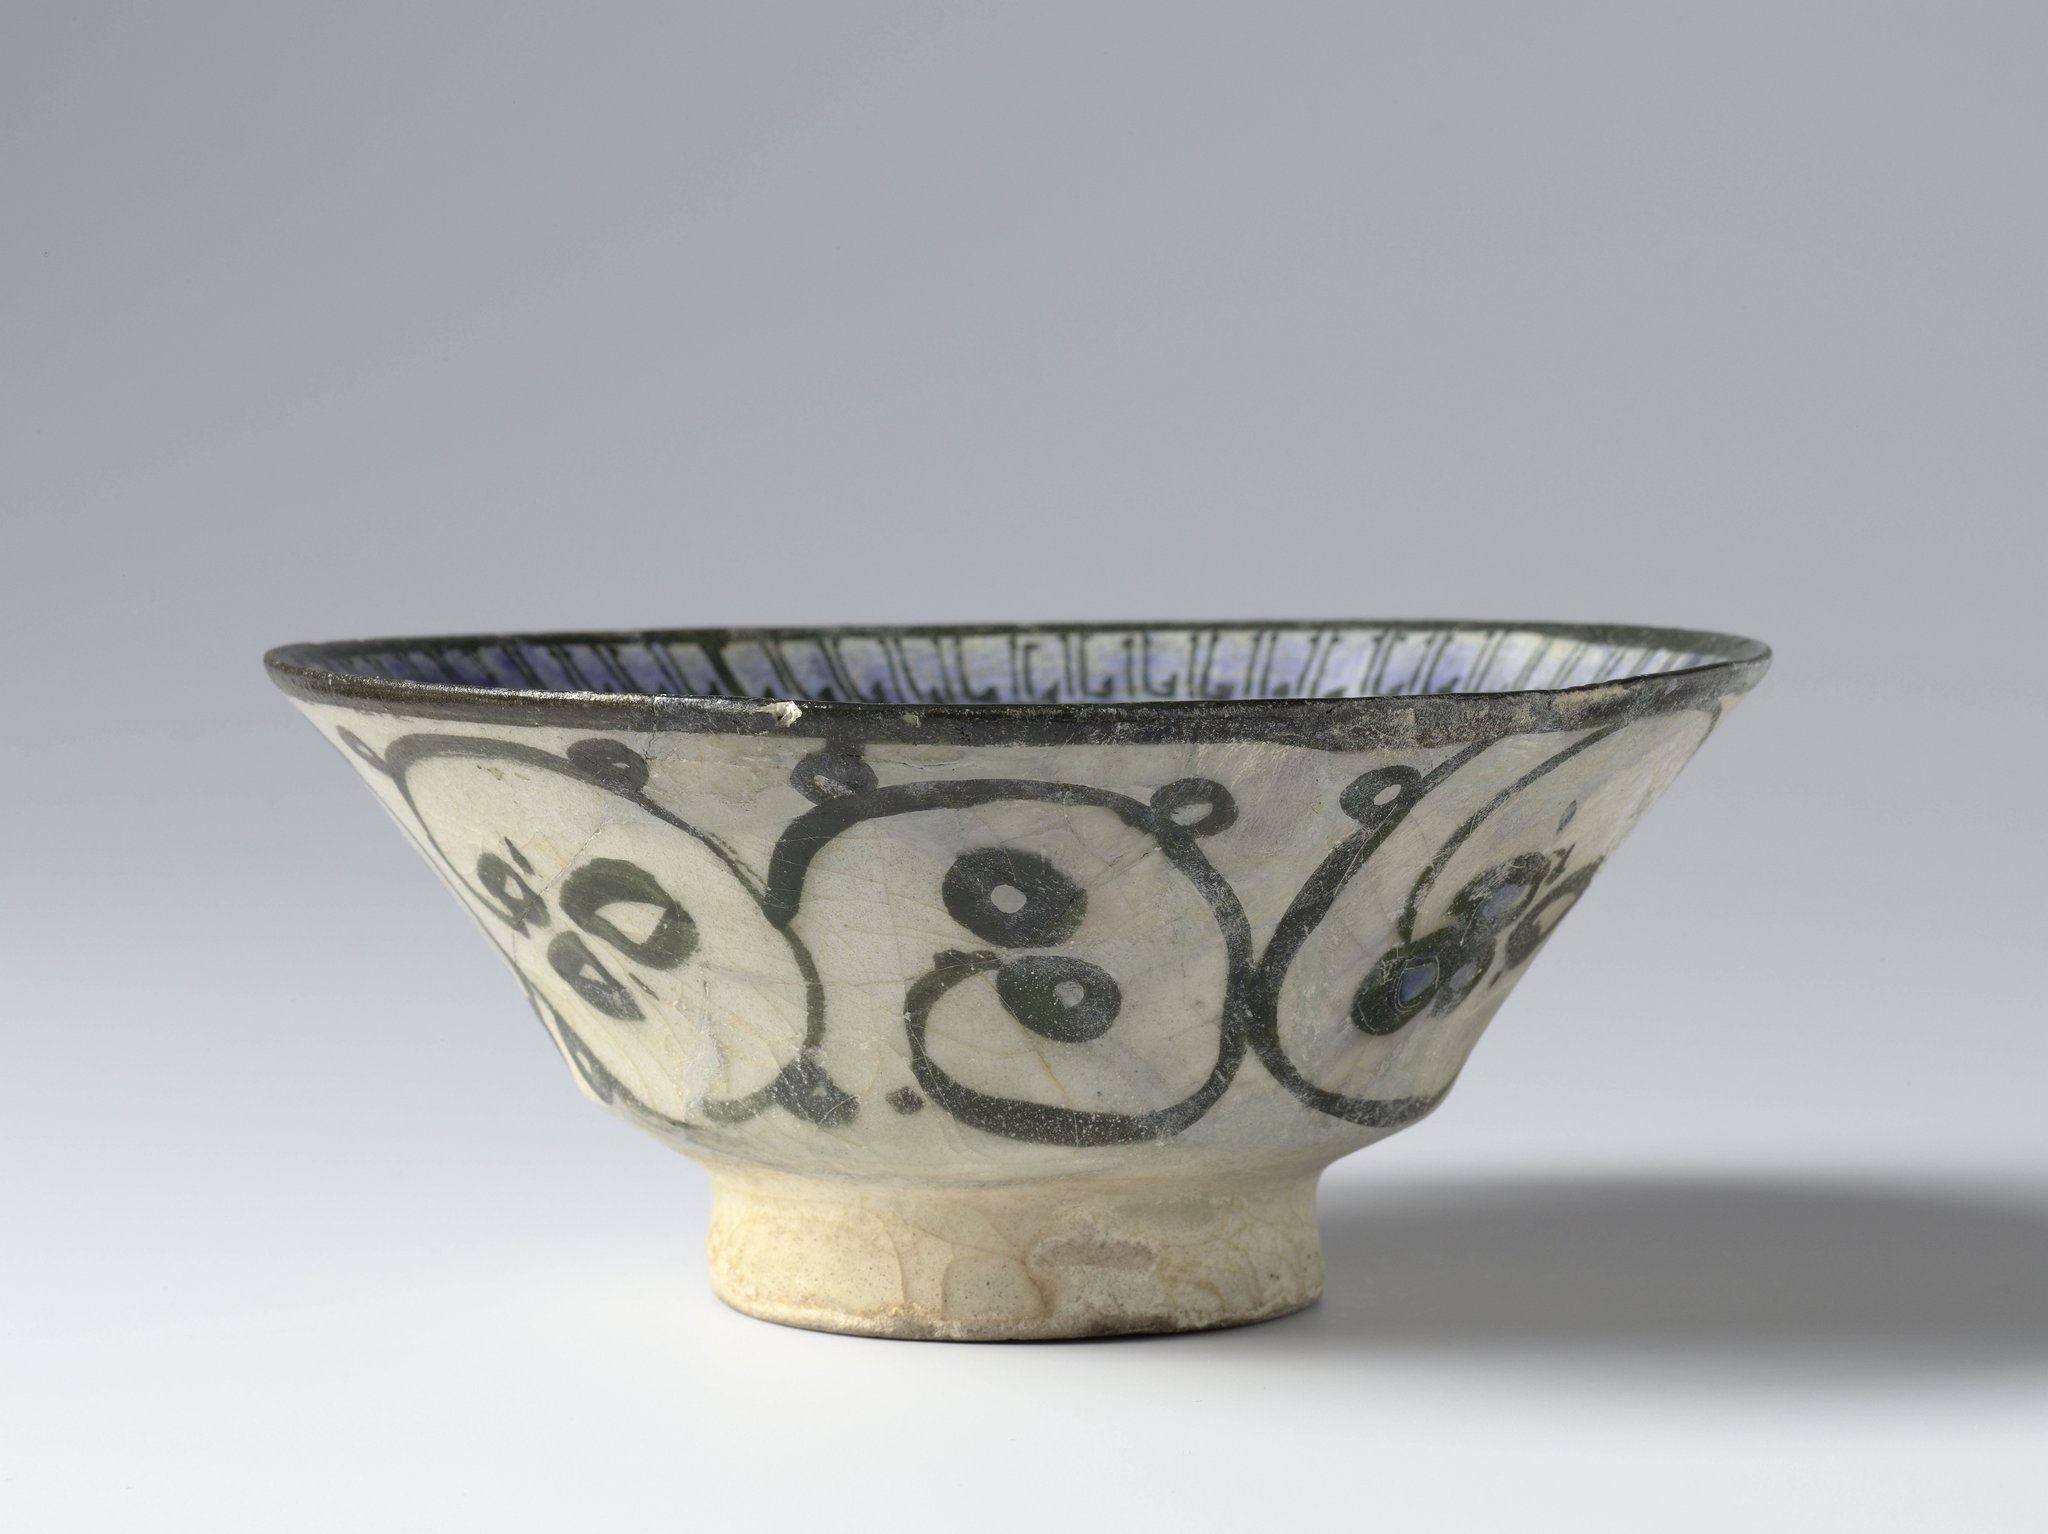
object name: bowl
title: Bowl with pseudo-inscription and scrolls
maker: Anonymous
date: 1200-1299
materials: cobalt, earthenware, glaze, paint, quartz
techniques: firing, turning, vitrification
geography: iran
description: Kom van kwarts-fritgoed met een beschildering van pseudo-schrift en ranken in bruin en blauw onder transparant alkaliglazuur.